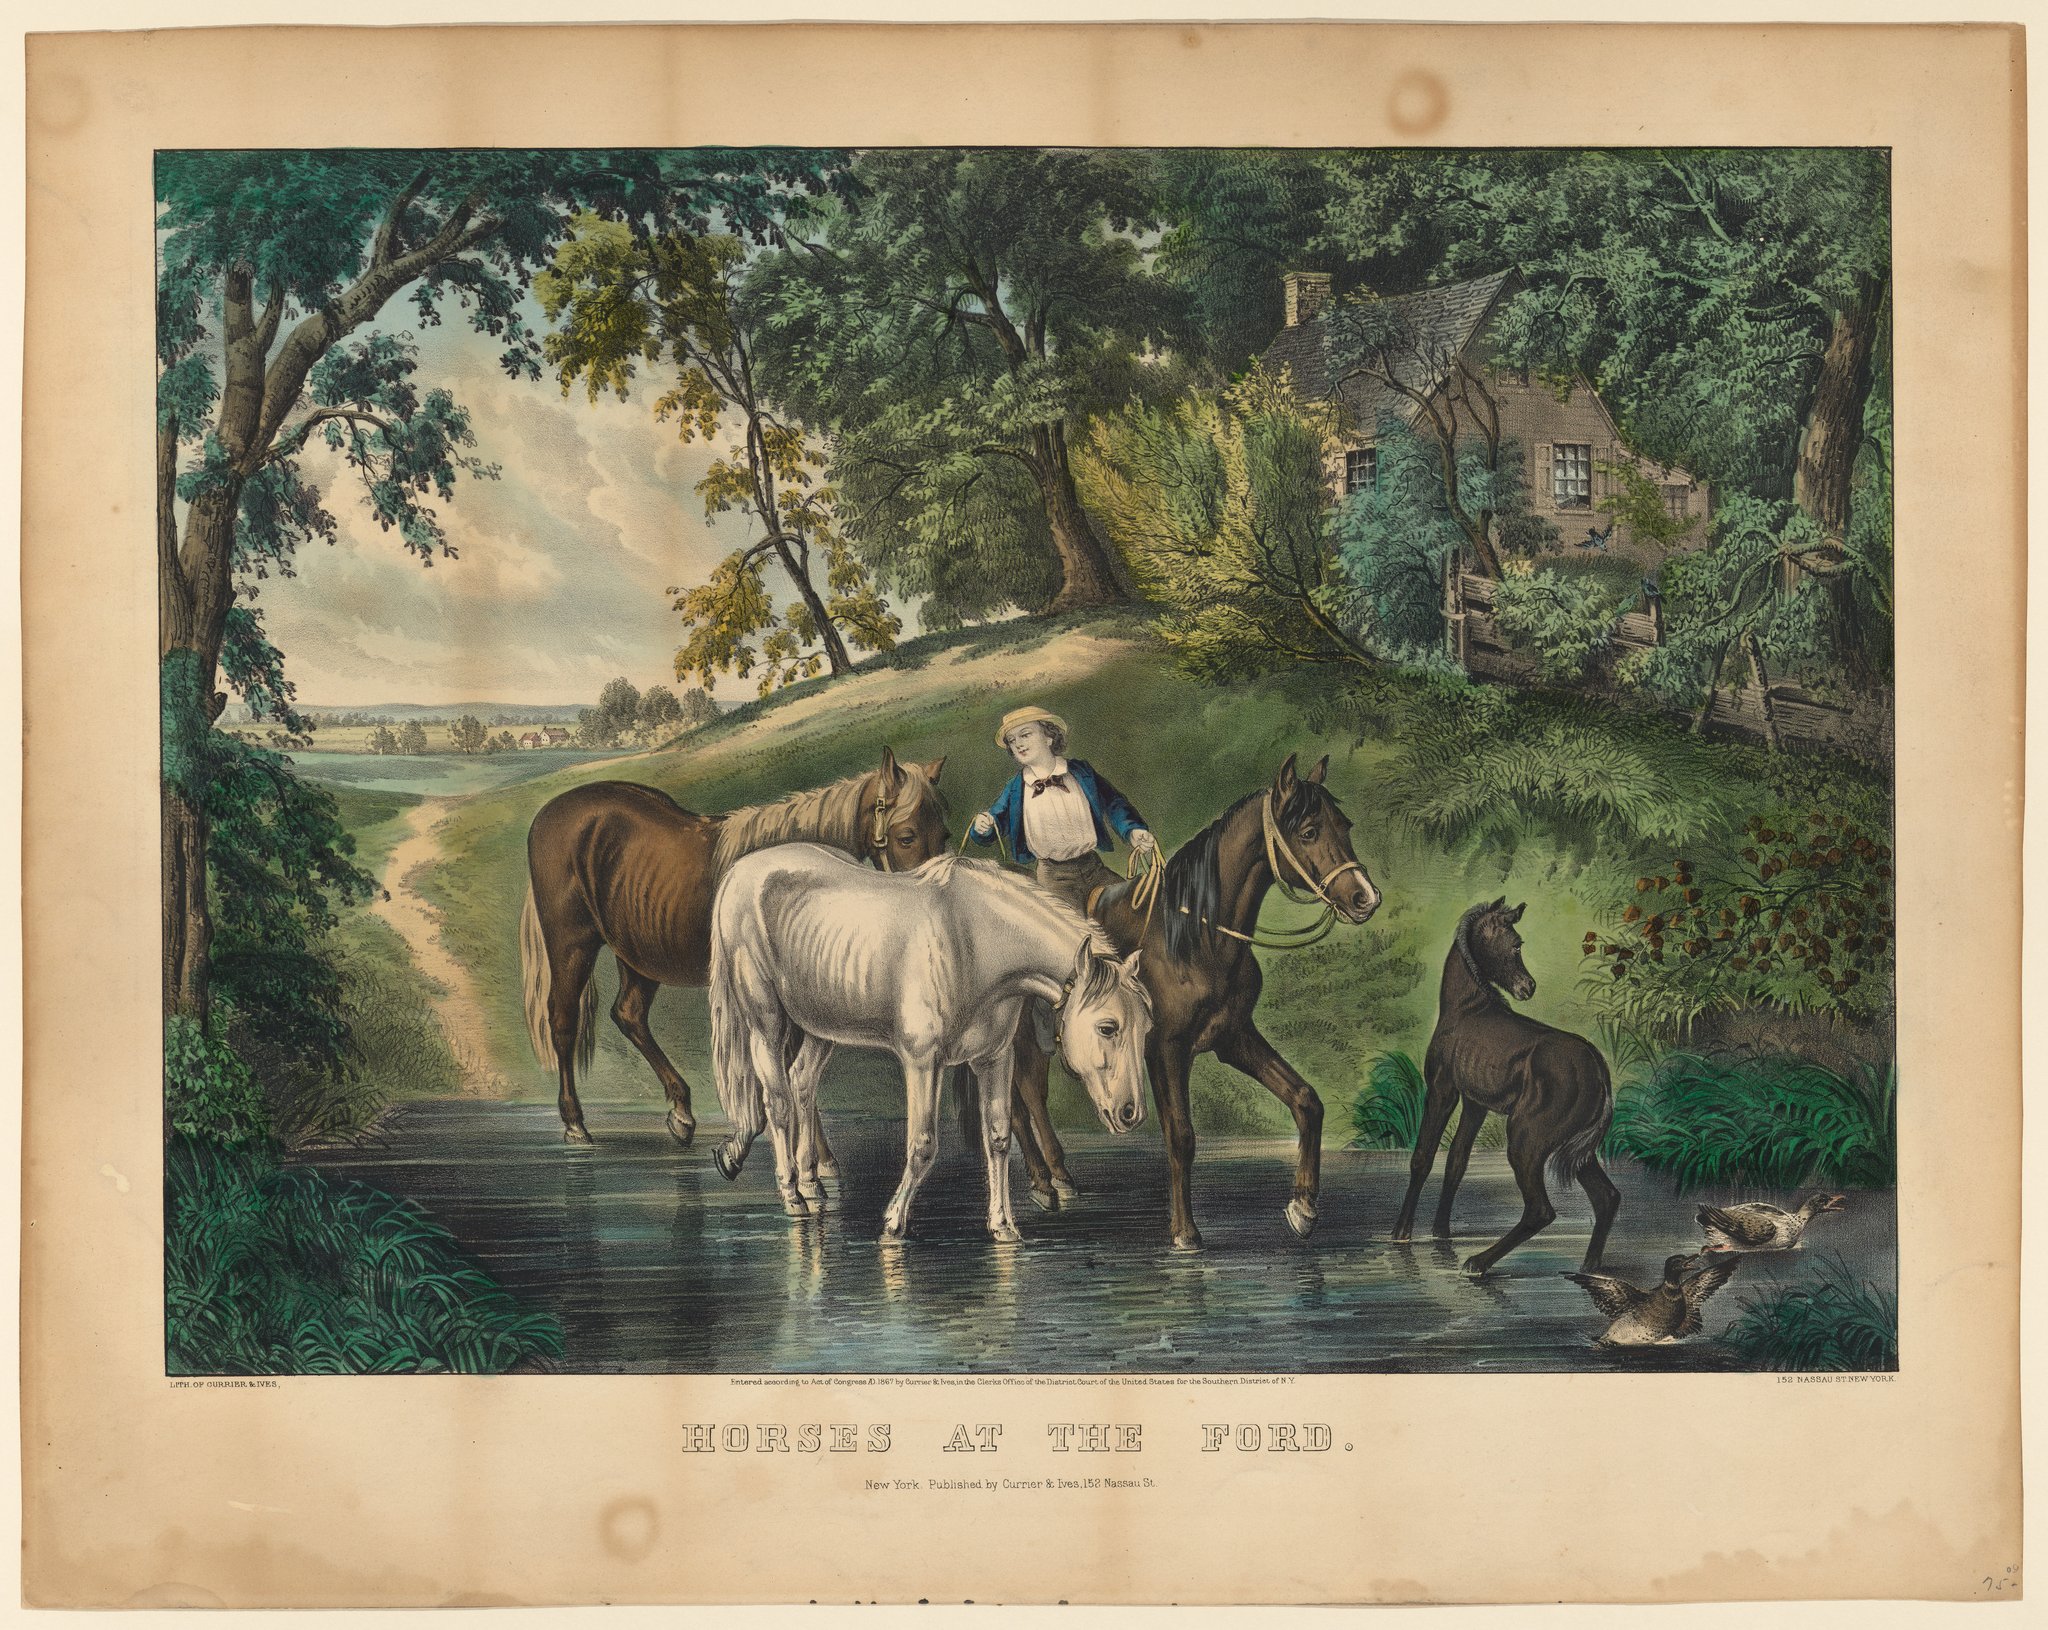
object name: print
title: Horses at the Ford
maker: currier & ives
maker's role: publisher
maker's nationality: american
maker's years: 1857-1907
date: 1867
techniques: hand coloring, lithograph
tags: horses